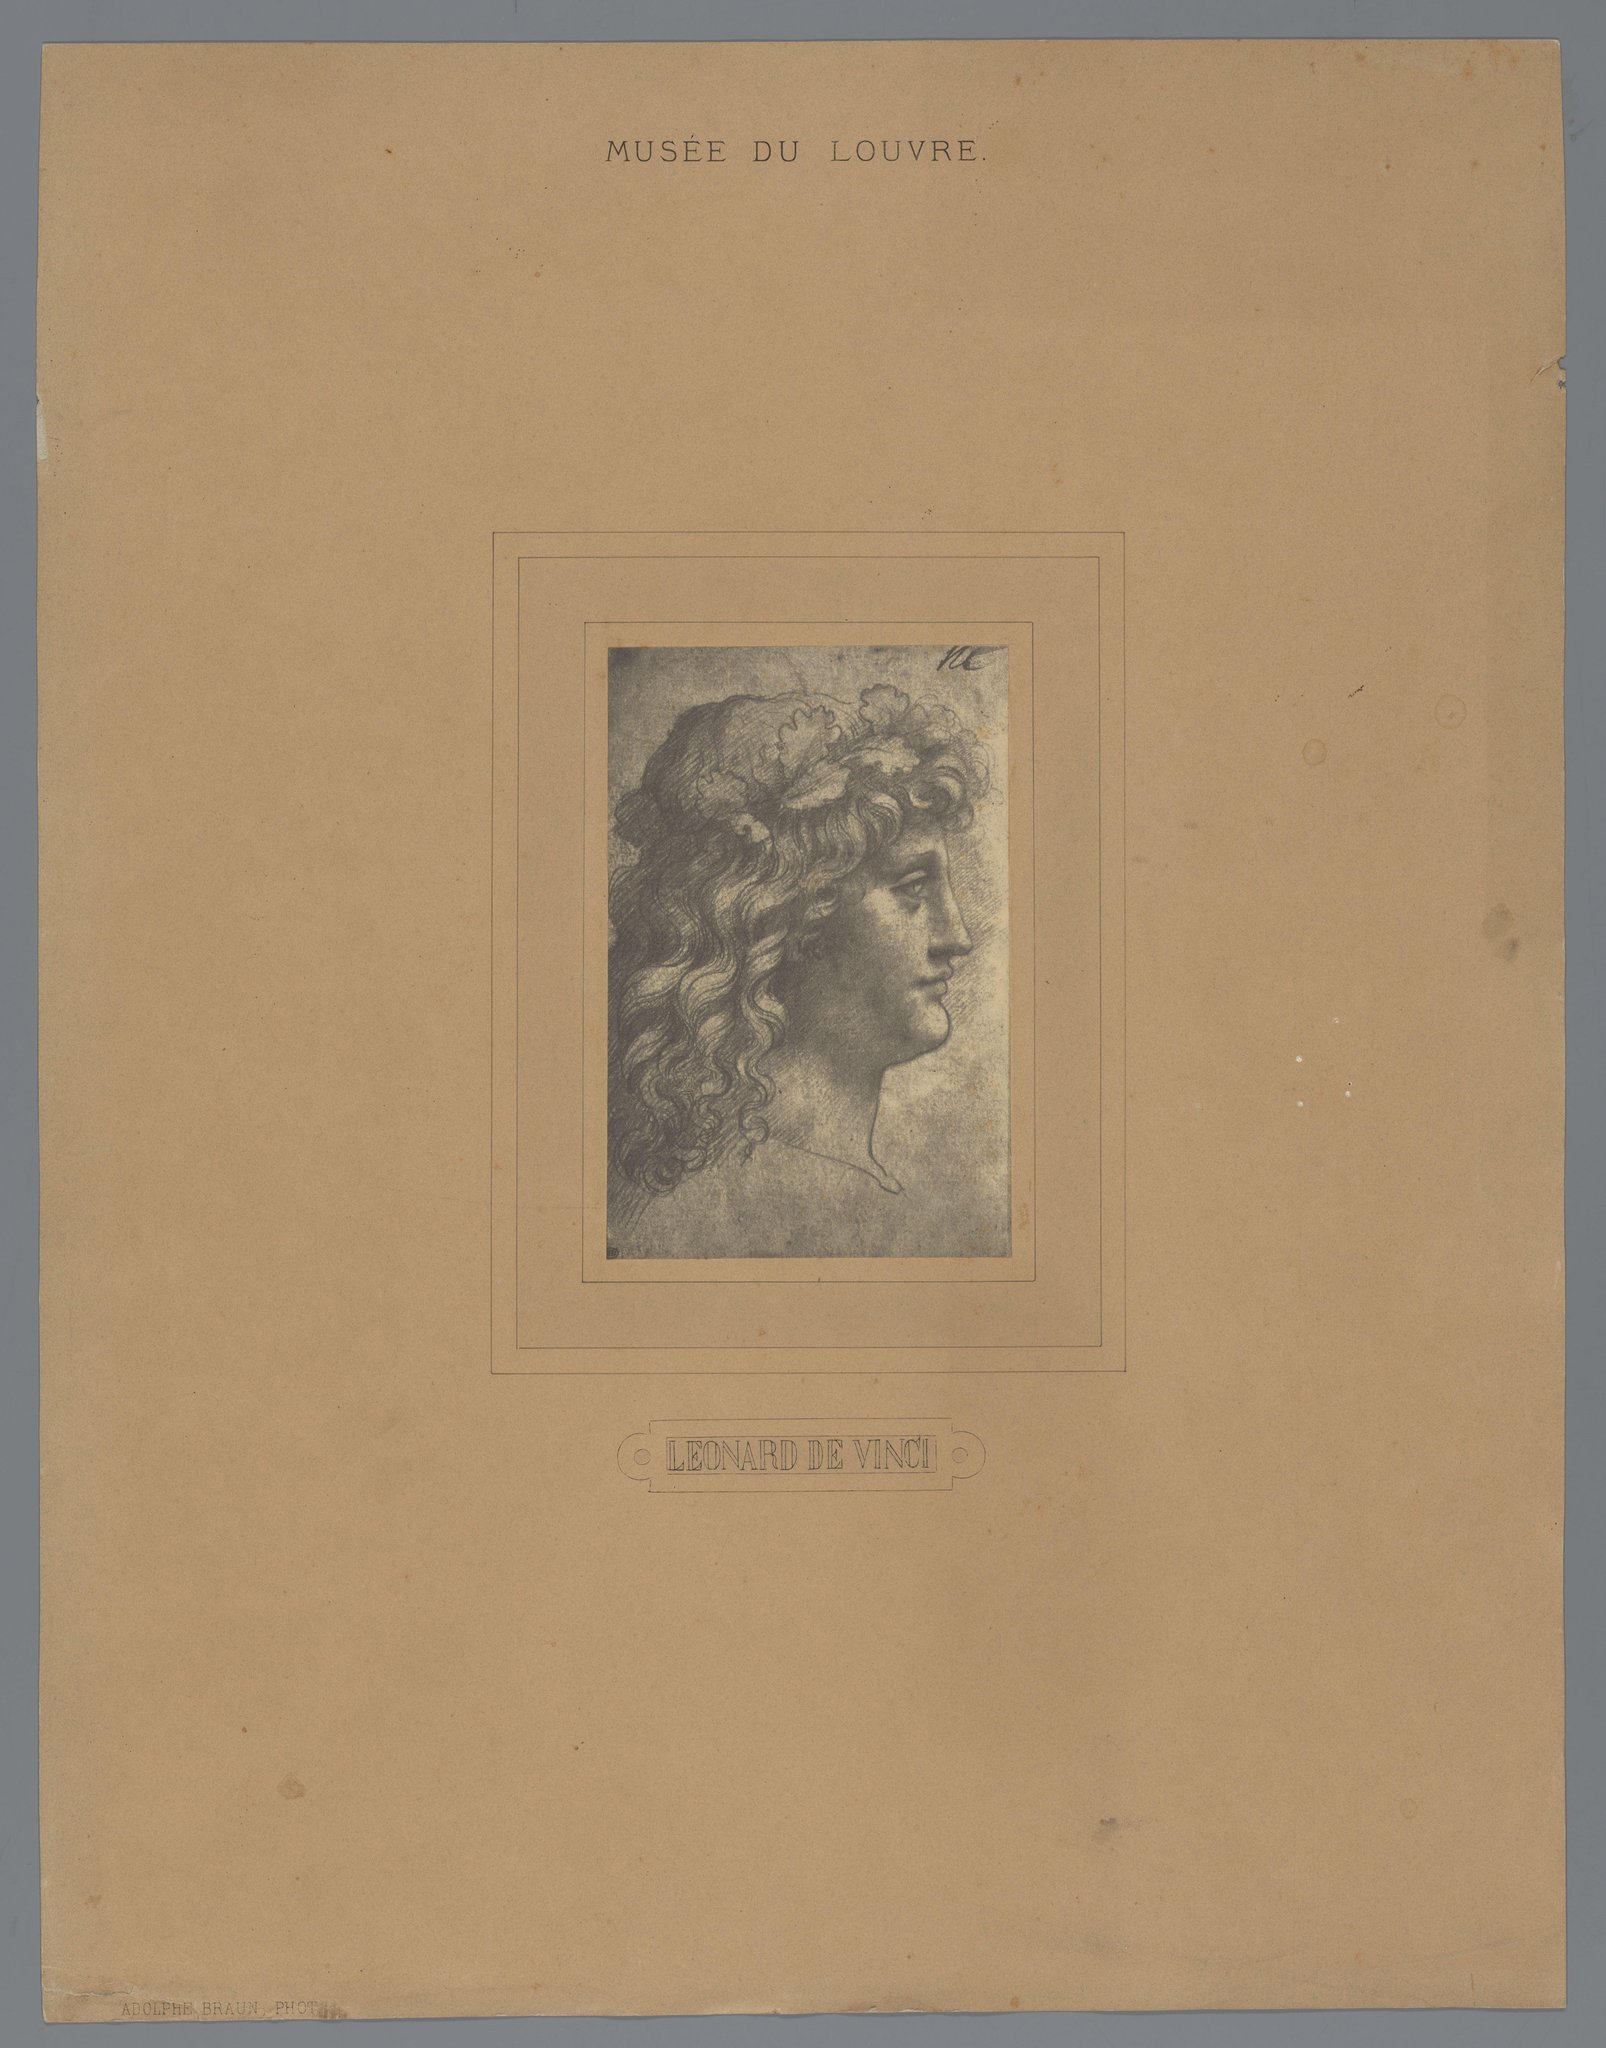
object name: photograph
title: Fotoreproductie van een tekening van Leonardo da Vinci (kop van een man)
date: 1880-1900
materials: cardboard, paper, photographic support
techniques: carbon print